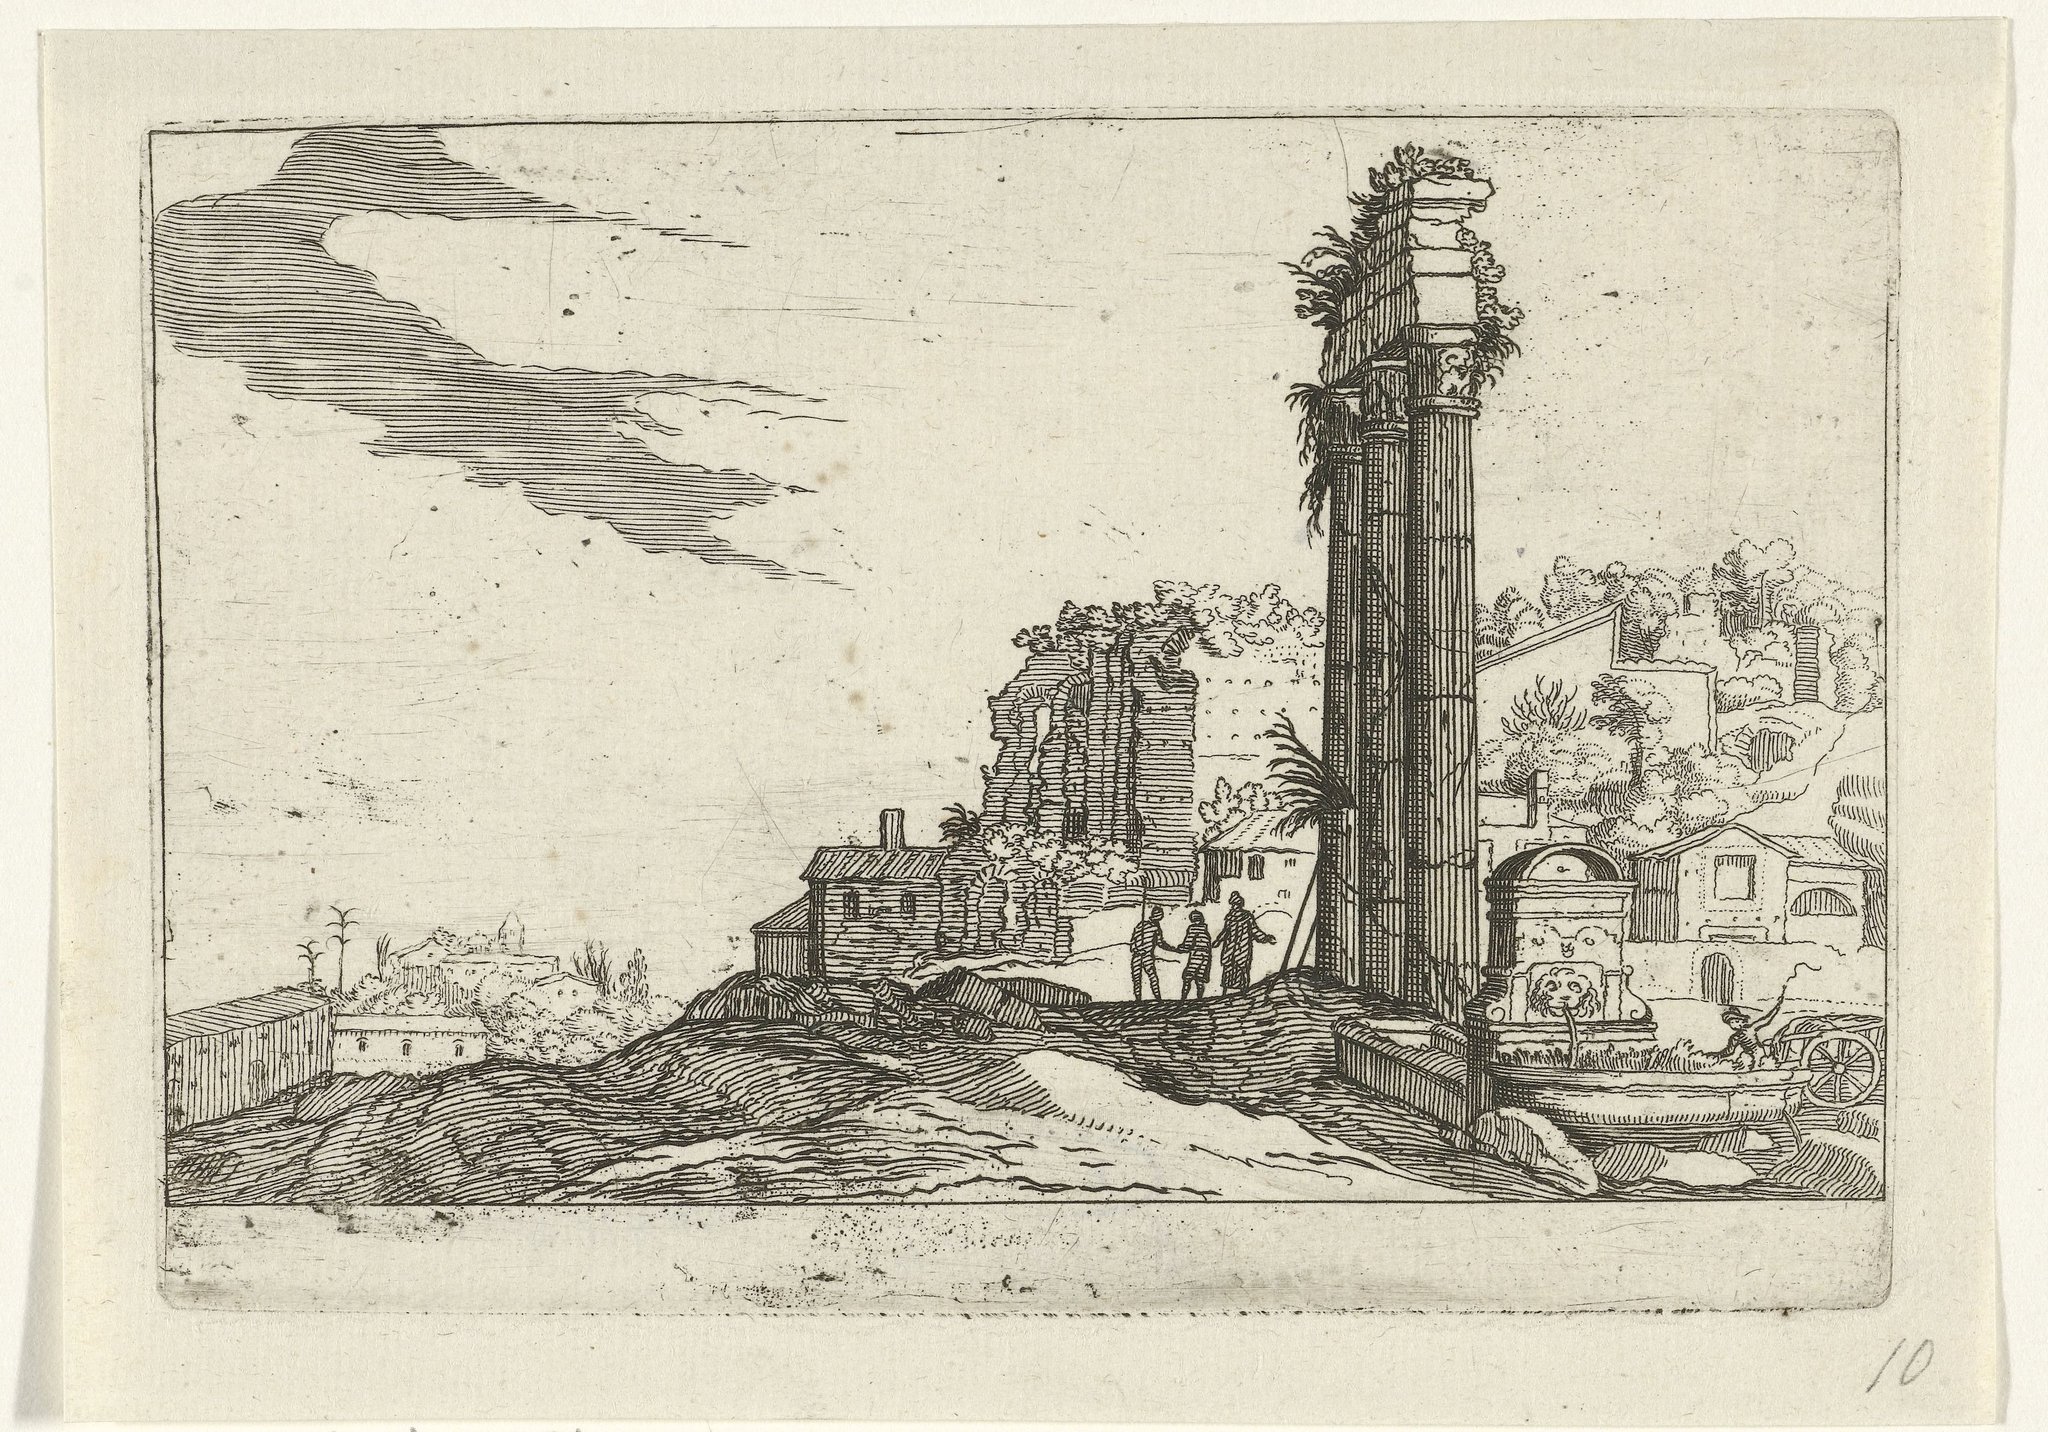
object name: print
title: Romeinse ruïnes (serie 2)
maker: Anonymous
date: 1594-1685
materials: paper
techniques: engraving, etching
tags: landscape with ruins, rome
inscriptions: collector's mark: Lugt 2228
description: De ruïne van de tempel van Castor en Pollux op het Forum Romanum in Rome. Daarnaast enkele figuren en een fontein. Prent uit een serie Romeinse ruïnes, bestaande uit kopieën naar een prentserie van Willem van Nieulandt.